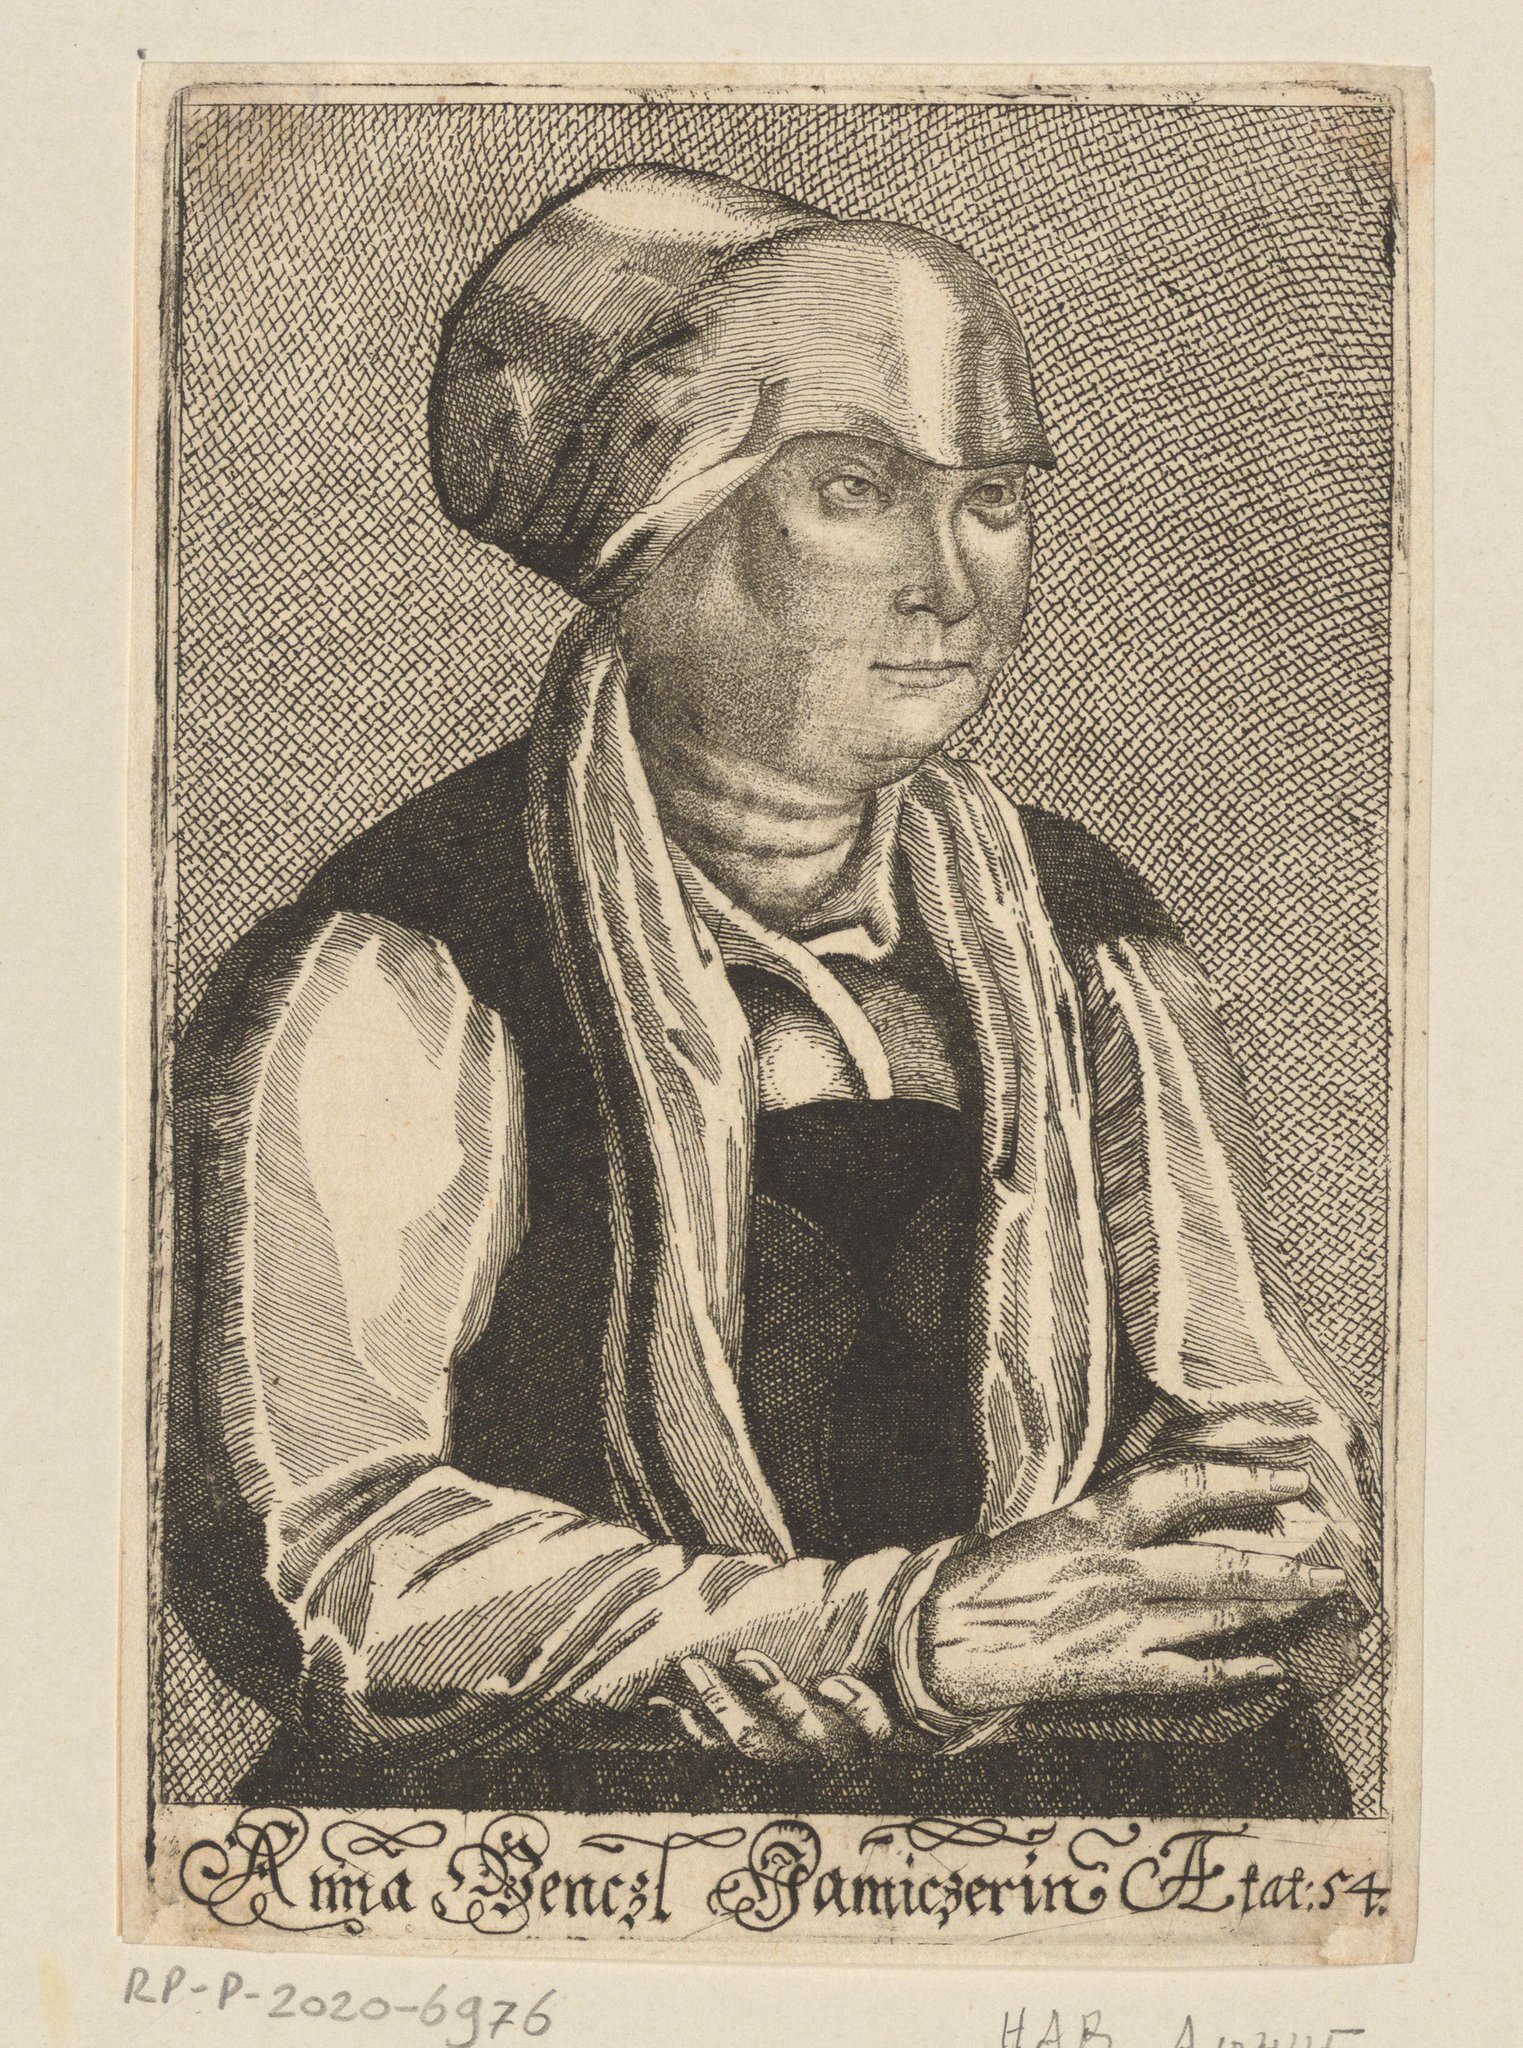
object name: print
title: Portret van Anna Jamnitzer op 54-jarige leeftijd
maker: Anonymous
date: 1650-1749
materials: paper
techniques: etching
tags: head-gear, historical persons - bb - woman